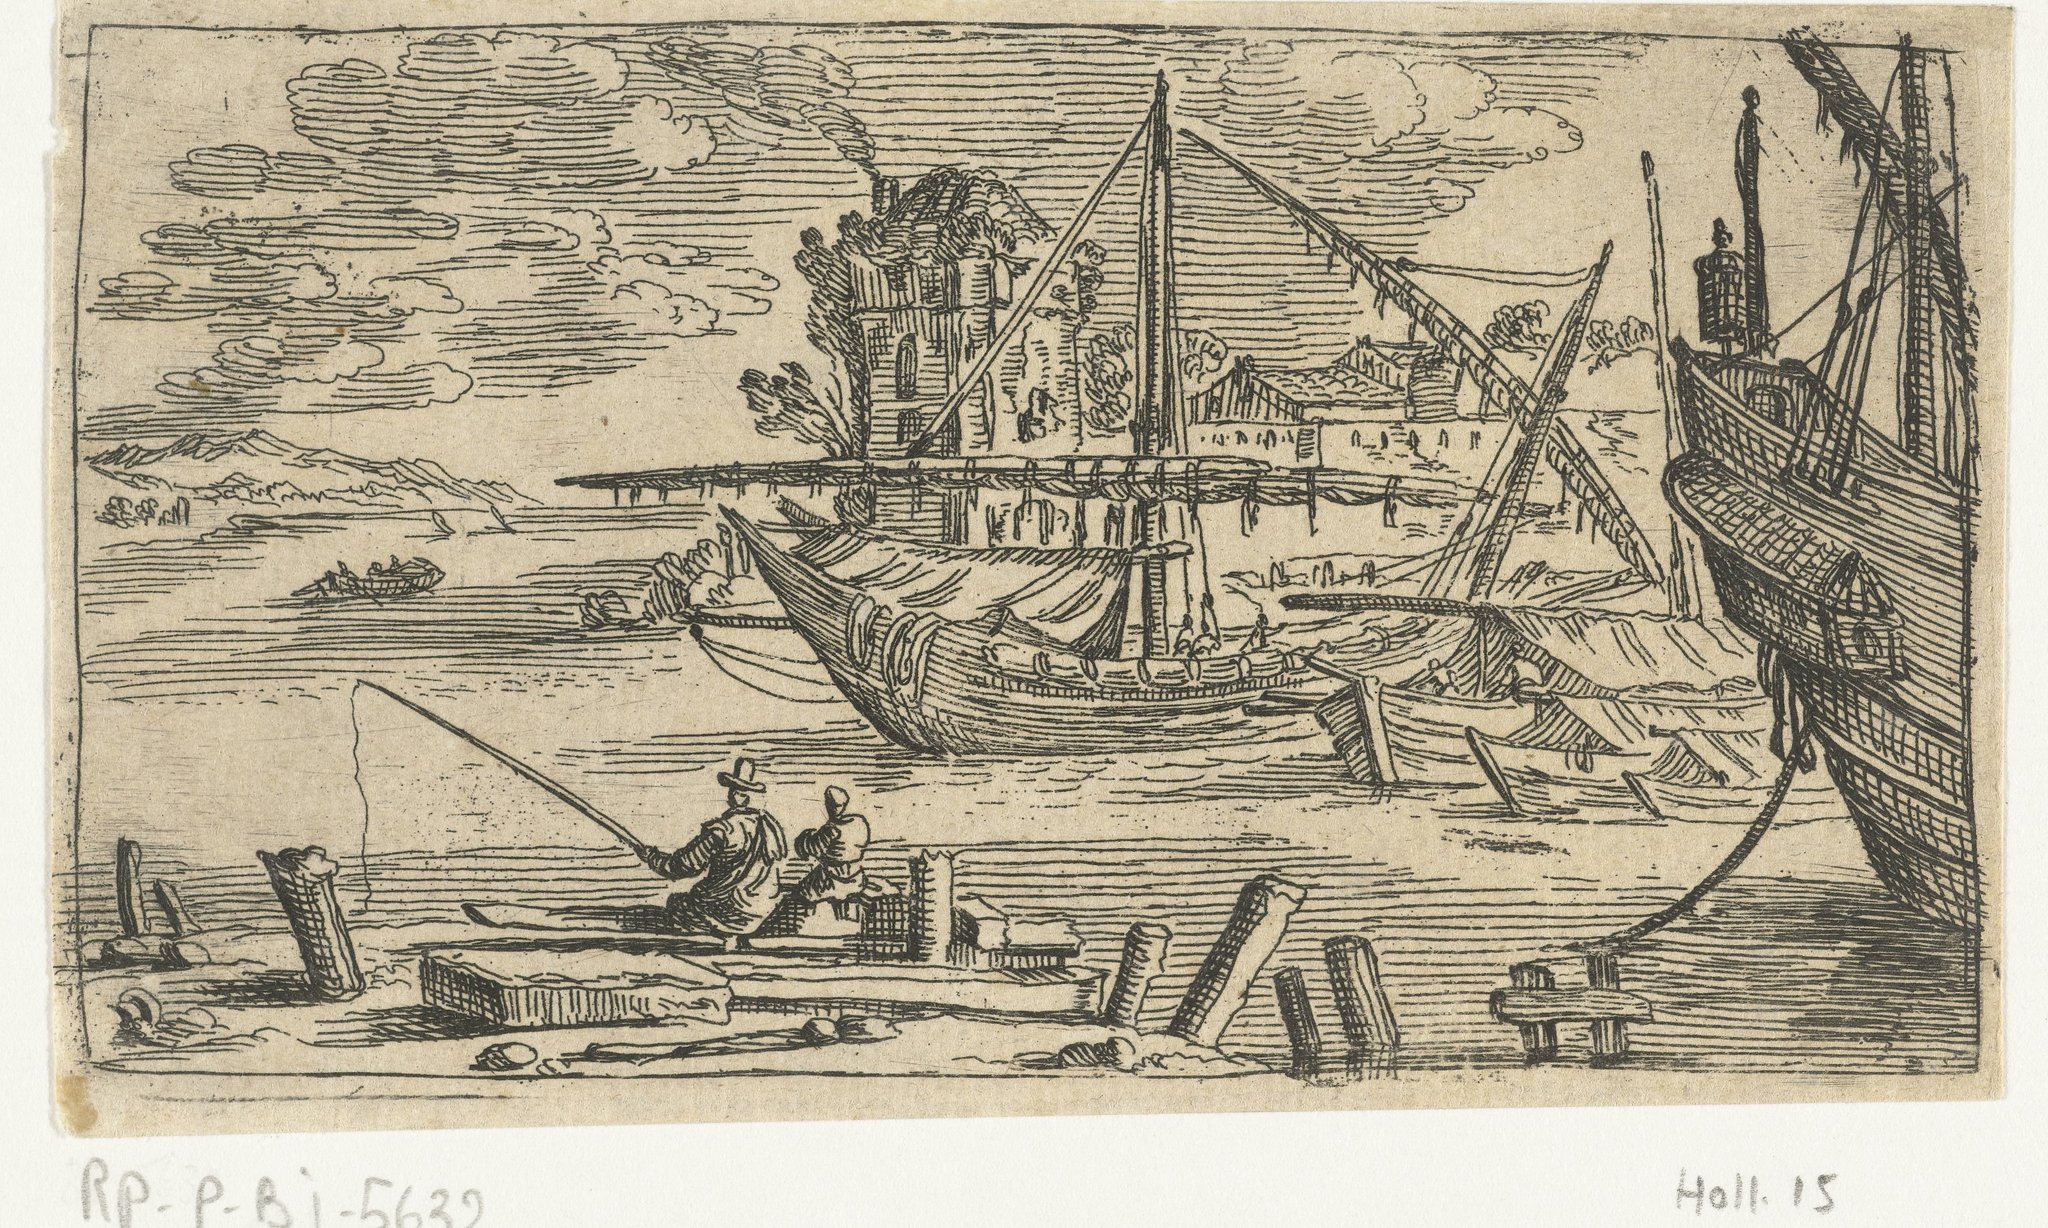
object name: print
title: Haven met hengelaar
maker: abraham de casembroot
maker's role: draughtsman, print maker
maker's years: 1573-1658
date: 1603-1658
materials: paper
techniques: etching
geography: southern netherlands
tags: harbour, fisherman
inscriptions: collector's mark: Lugt 2166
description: Een haven met enkele vissersbootjes. Op de voorgrond een hengelaar op de kade.